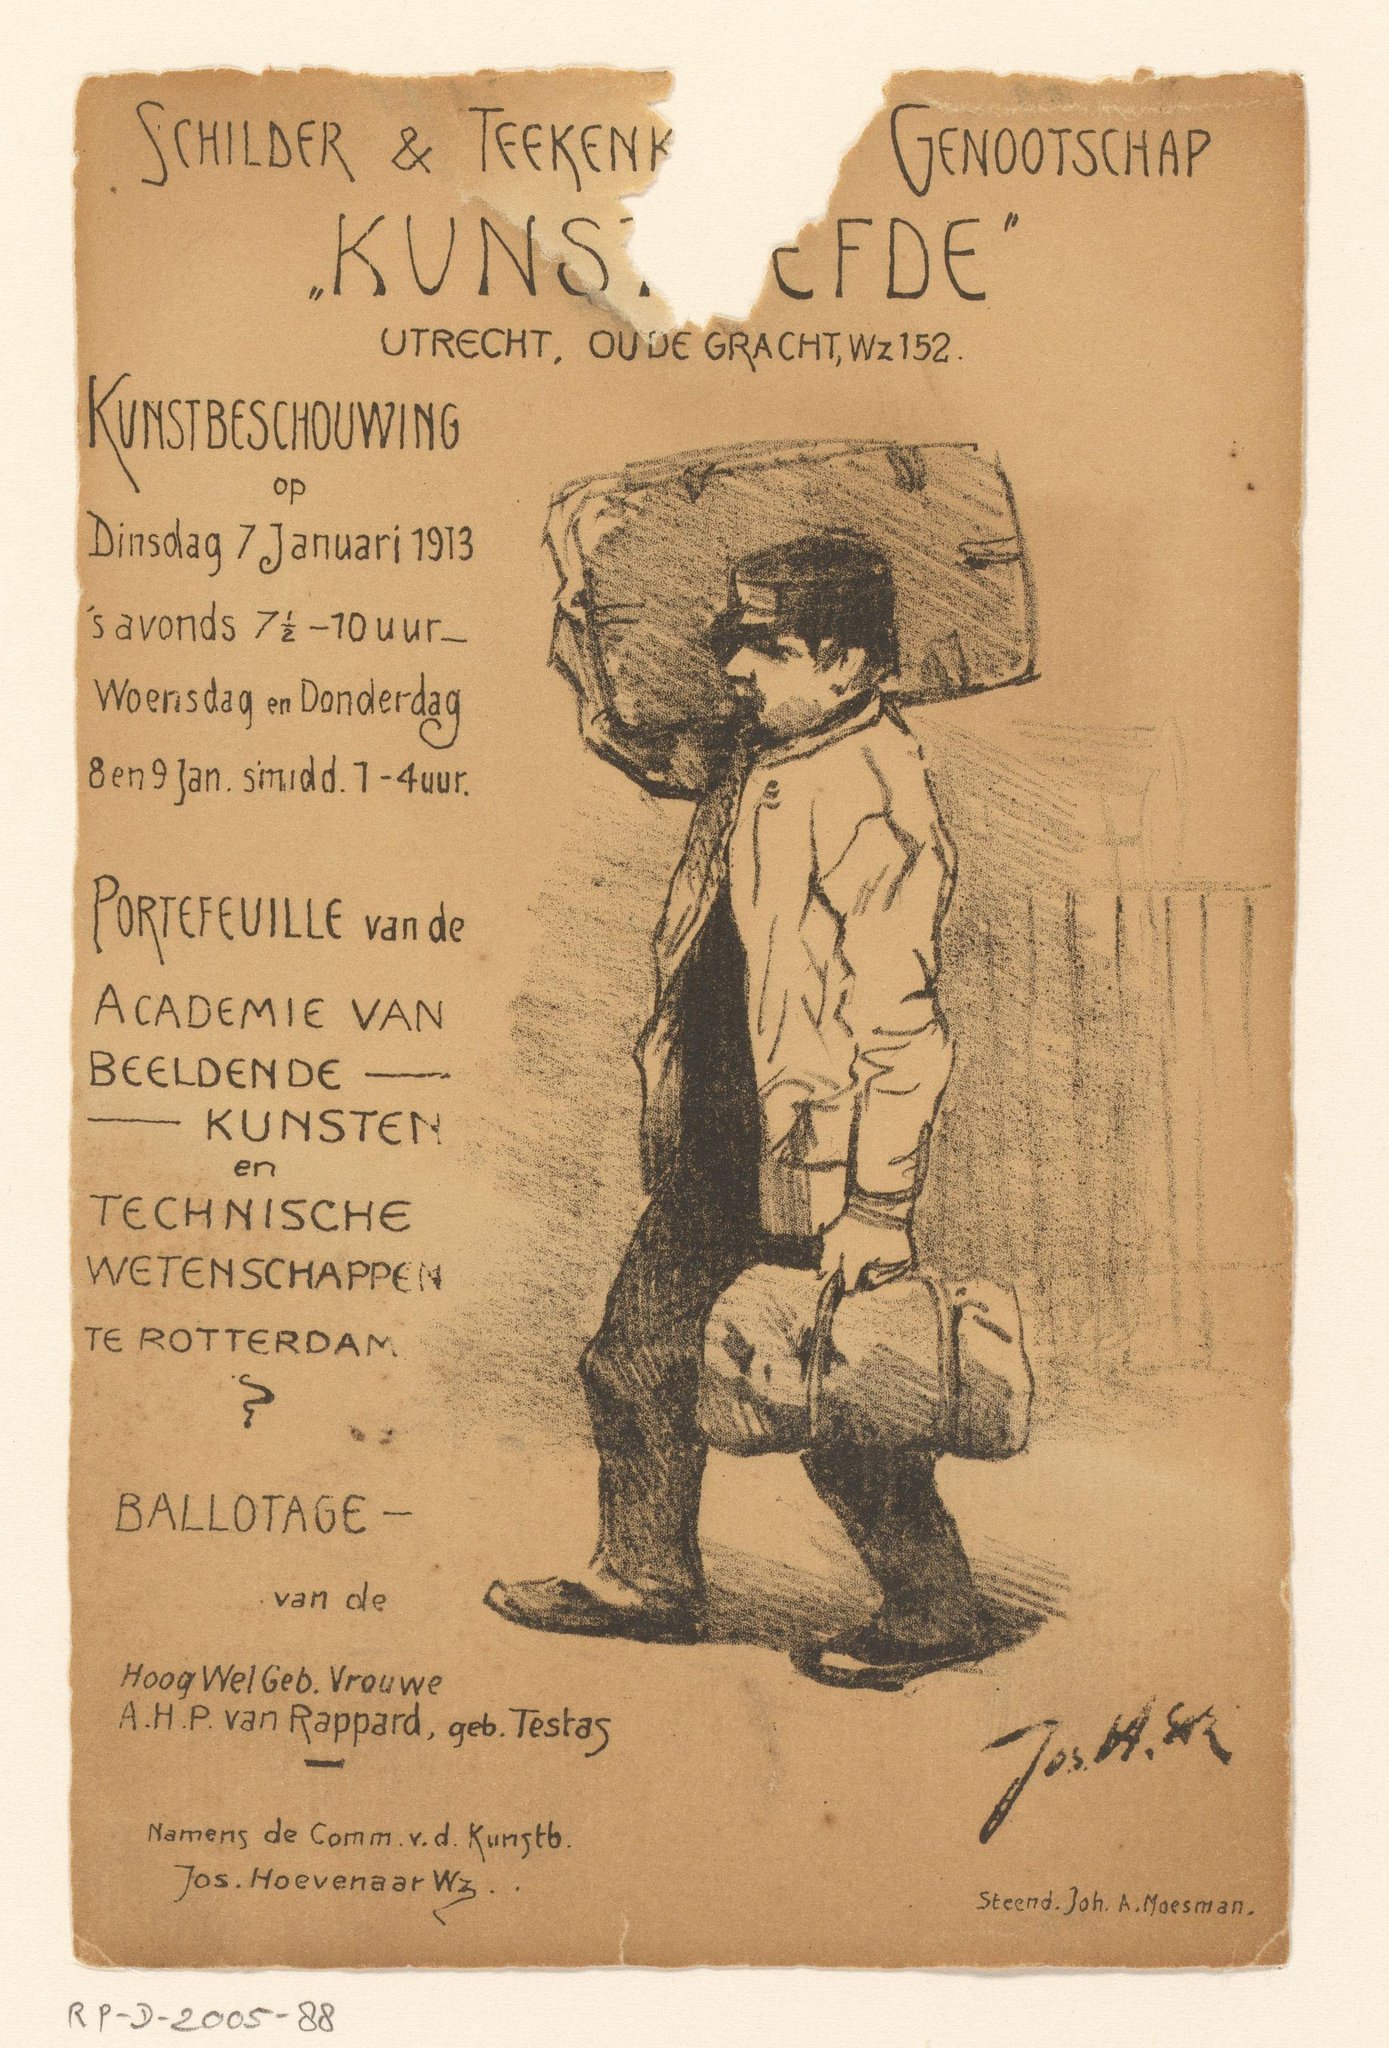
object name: invitation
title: Uitnodiging van Schilder- en Teekenkundig Genootschap "Kunstliefde" voor een kunstbeschouwing, 7 januari 1913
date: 1901-1913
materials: paper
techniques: lithograph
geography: utrecht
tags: criticizing and discussing art, art criticism, circle, club of artists, collecting and exhibiting products of the fine arts, porter, bearer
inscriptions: collector's mark: Lugt 2228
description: Drager. Uitnodiging van Schilder- en Teekenkundig Genootschap "Kunstliefde" voor een kunstbeschouwing op 7 januari 1913 van de portefeuille van de Academie van Beeldende Kunsten en Technische Wetenschappen te Rotterdam.